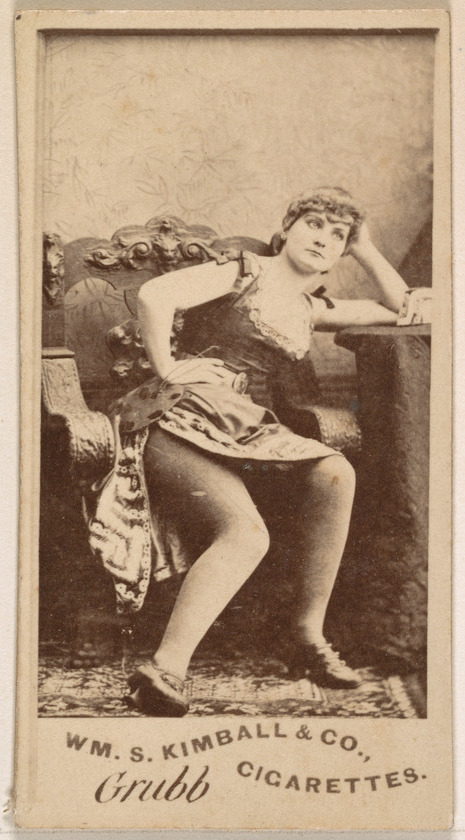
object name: photograph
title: Lillian Grubb, from the Actresses series (N203) issued by Wm. S. Kimball & Co.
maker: william s. kimball & company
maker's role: publisher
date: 1889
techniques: color lithograph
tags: portraits,women,actresses